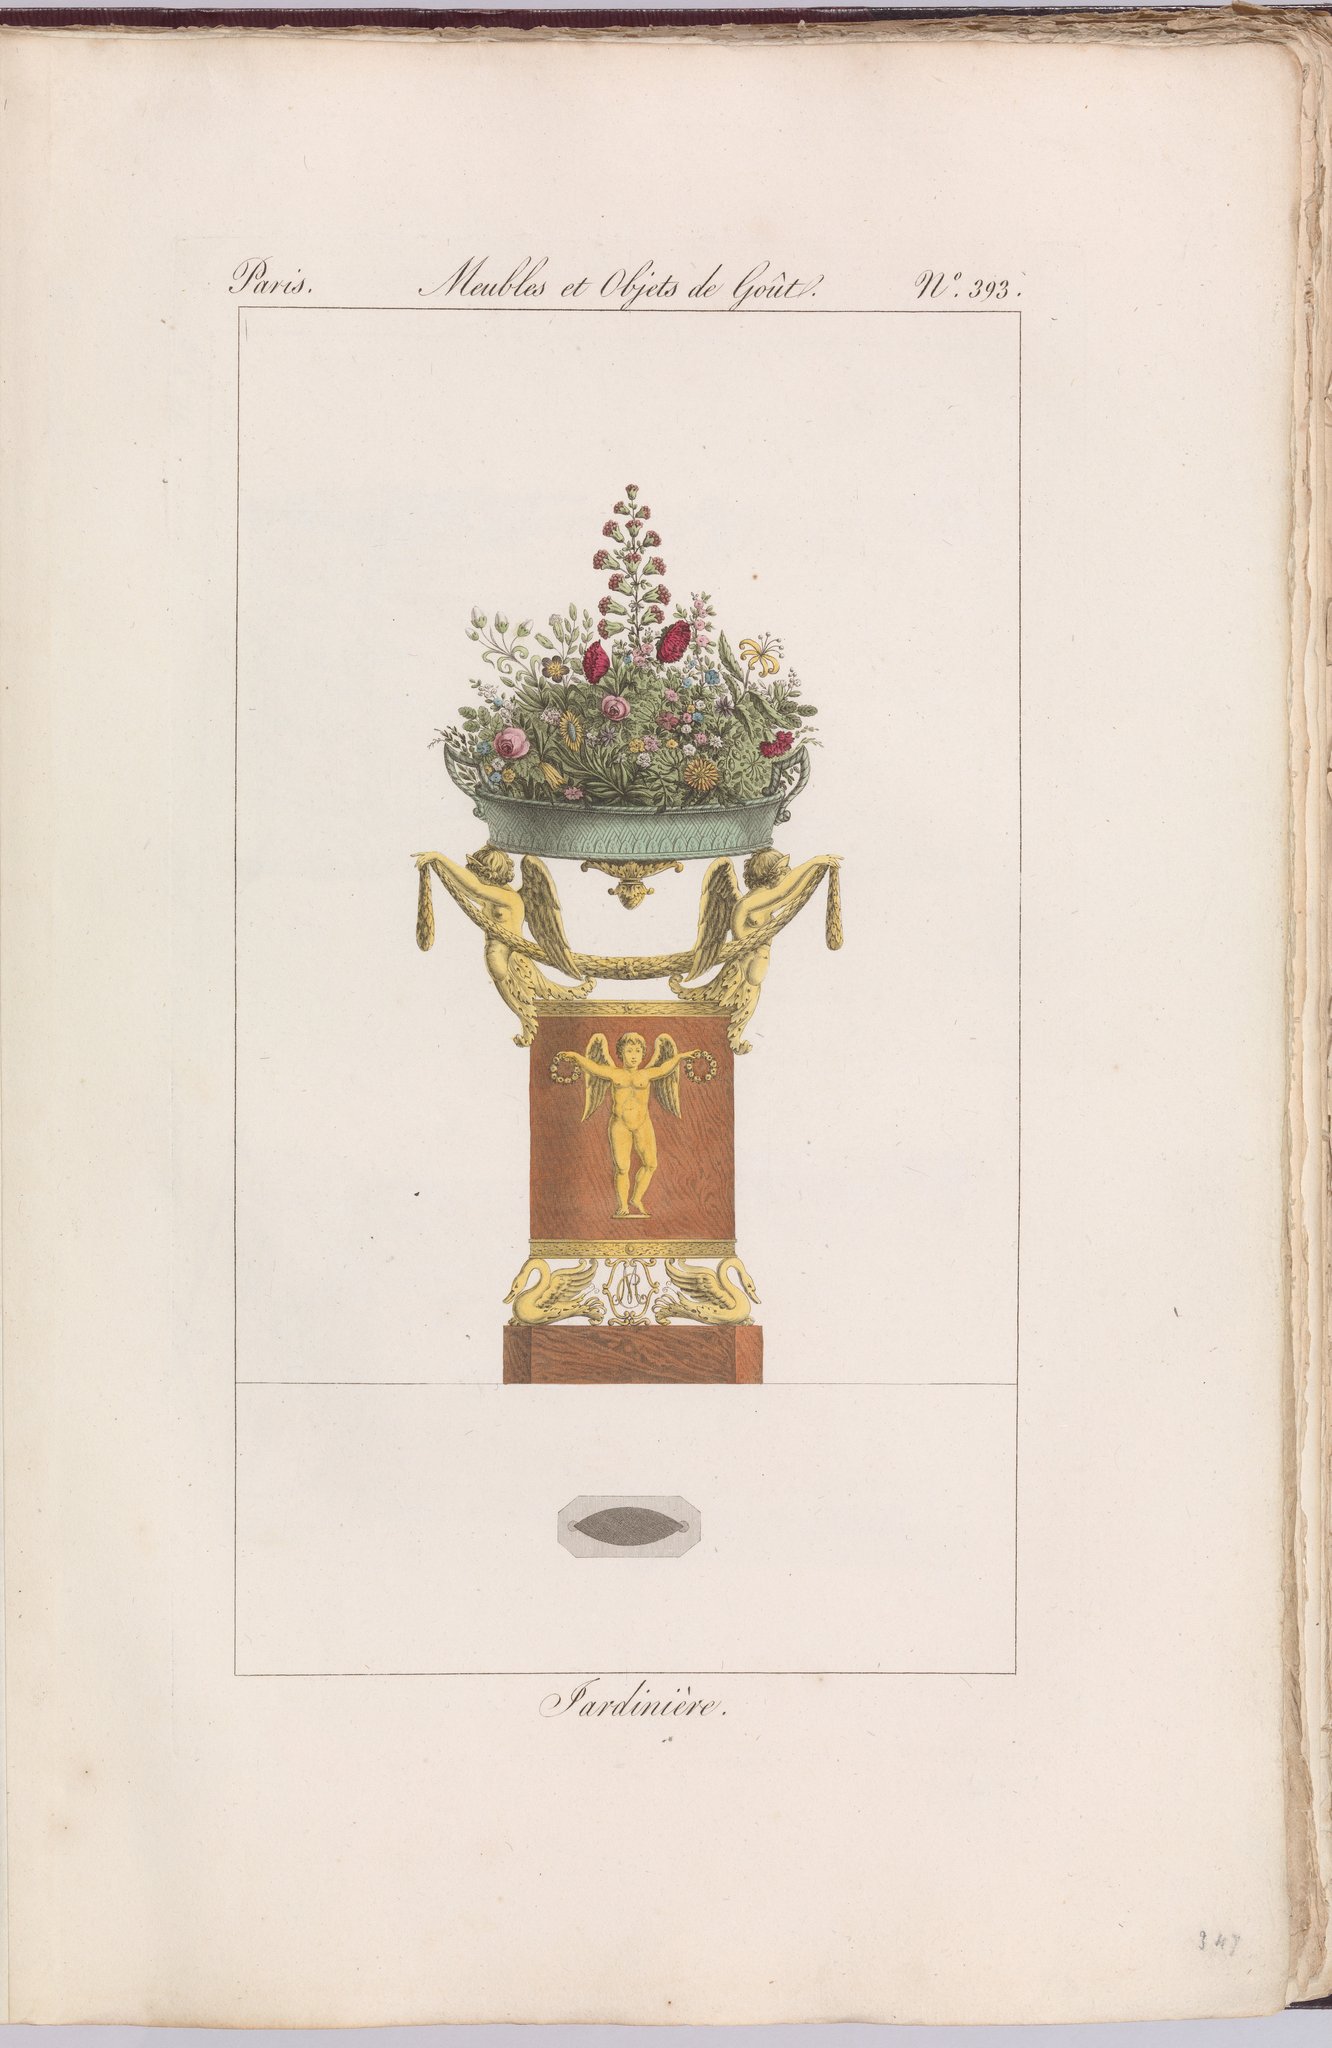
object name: book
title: Collection de Meubles et Objets de Goût, vol. 2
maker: pierre de la mésangère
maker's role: editor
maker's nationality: french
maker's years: 1761-1831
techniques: engraving, hand coloring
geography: france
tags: furniture